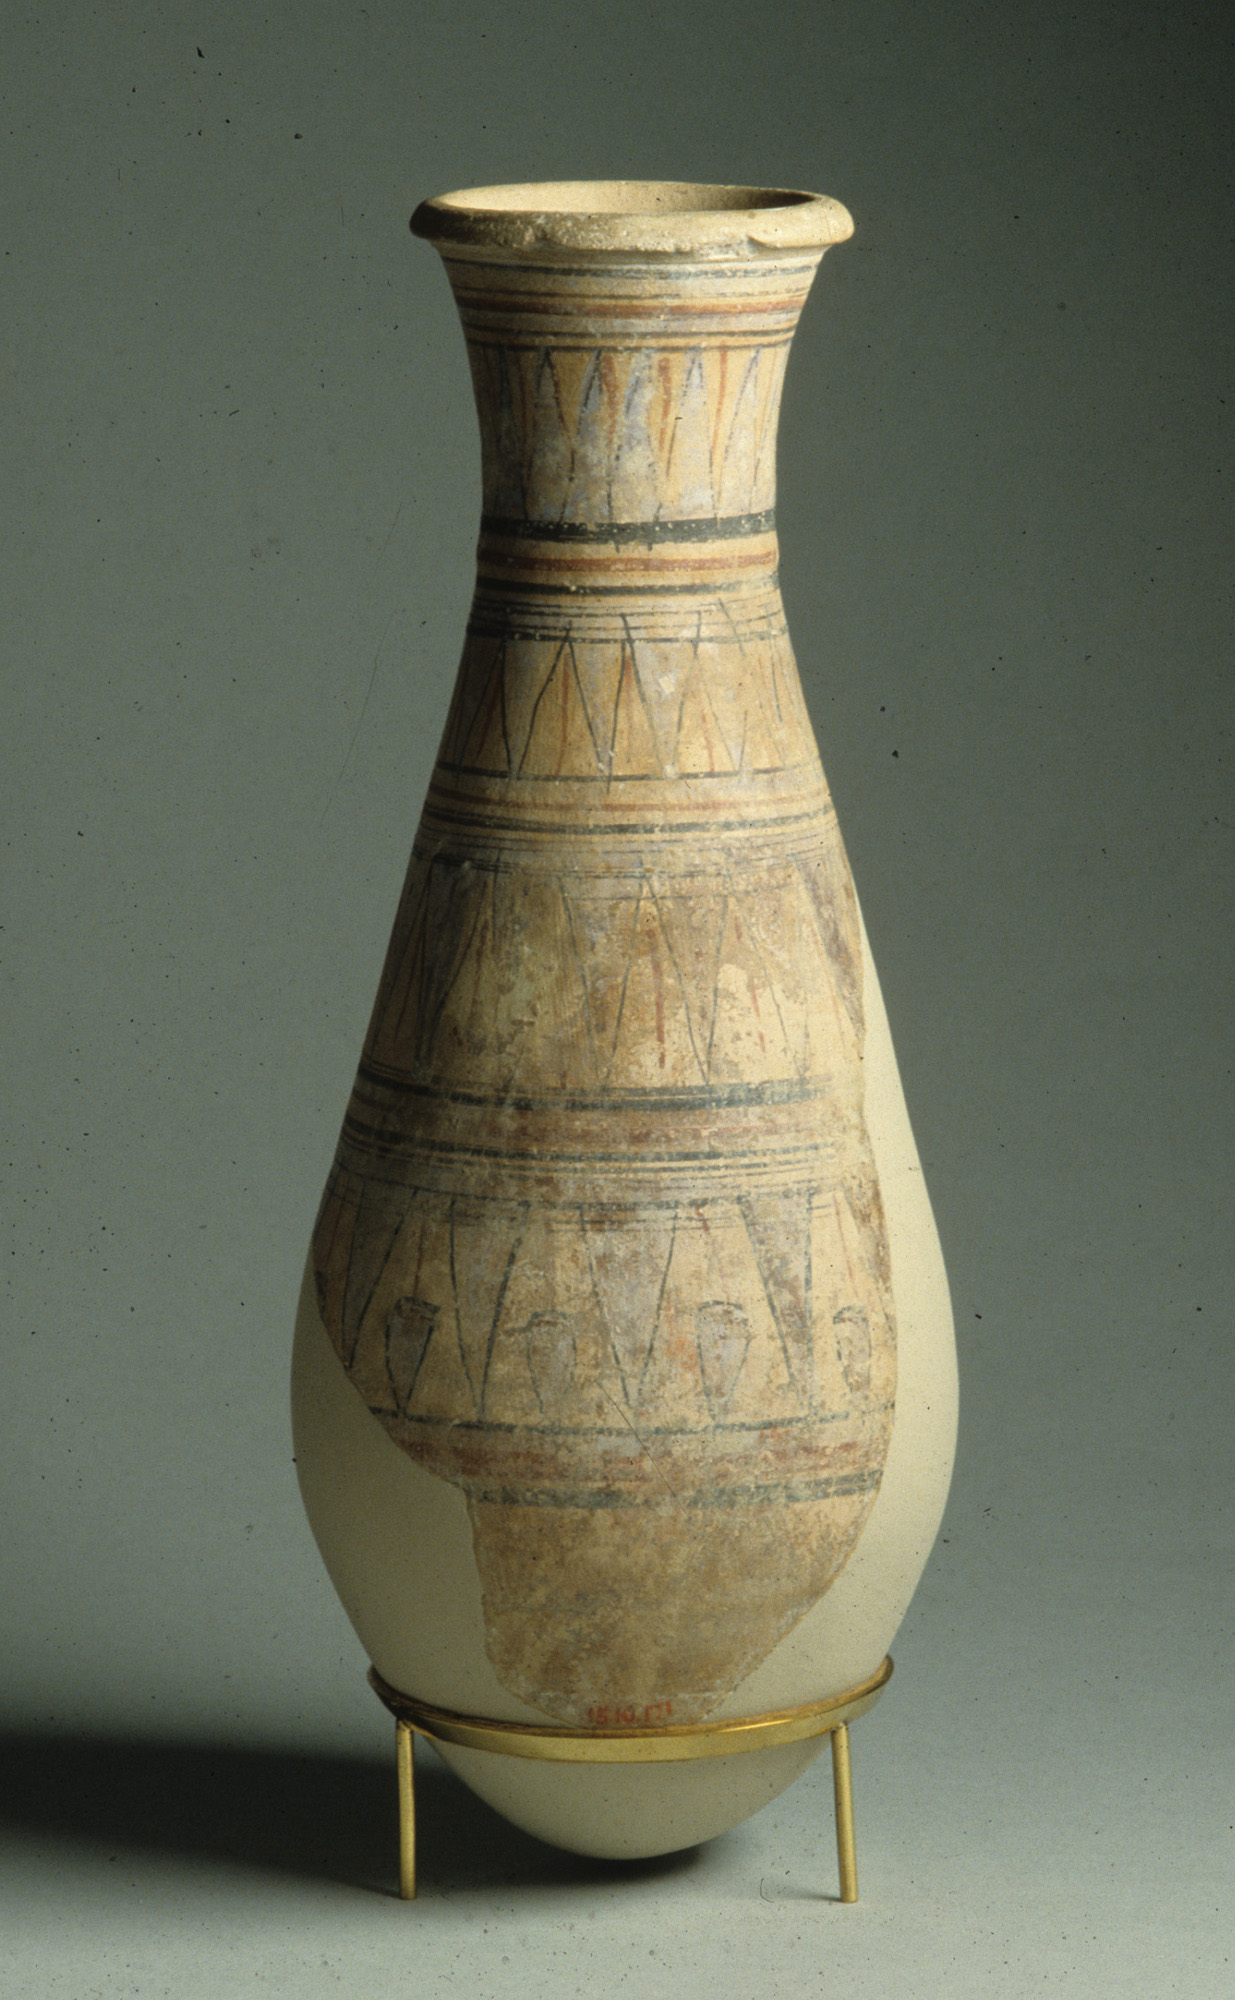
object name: vase, blue painted, nakht, tt 52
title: Blue-painted ware vase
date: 1410-1370 BCE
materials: pottery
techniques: painting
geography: egypt